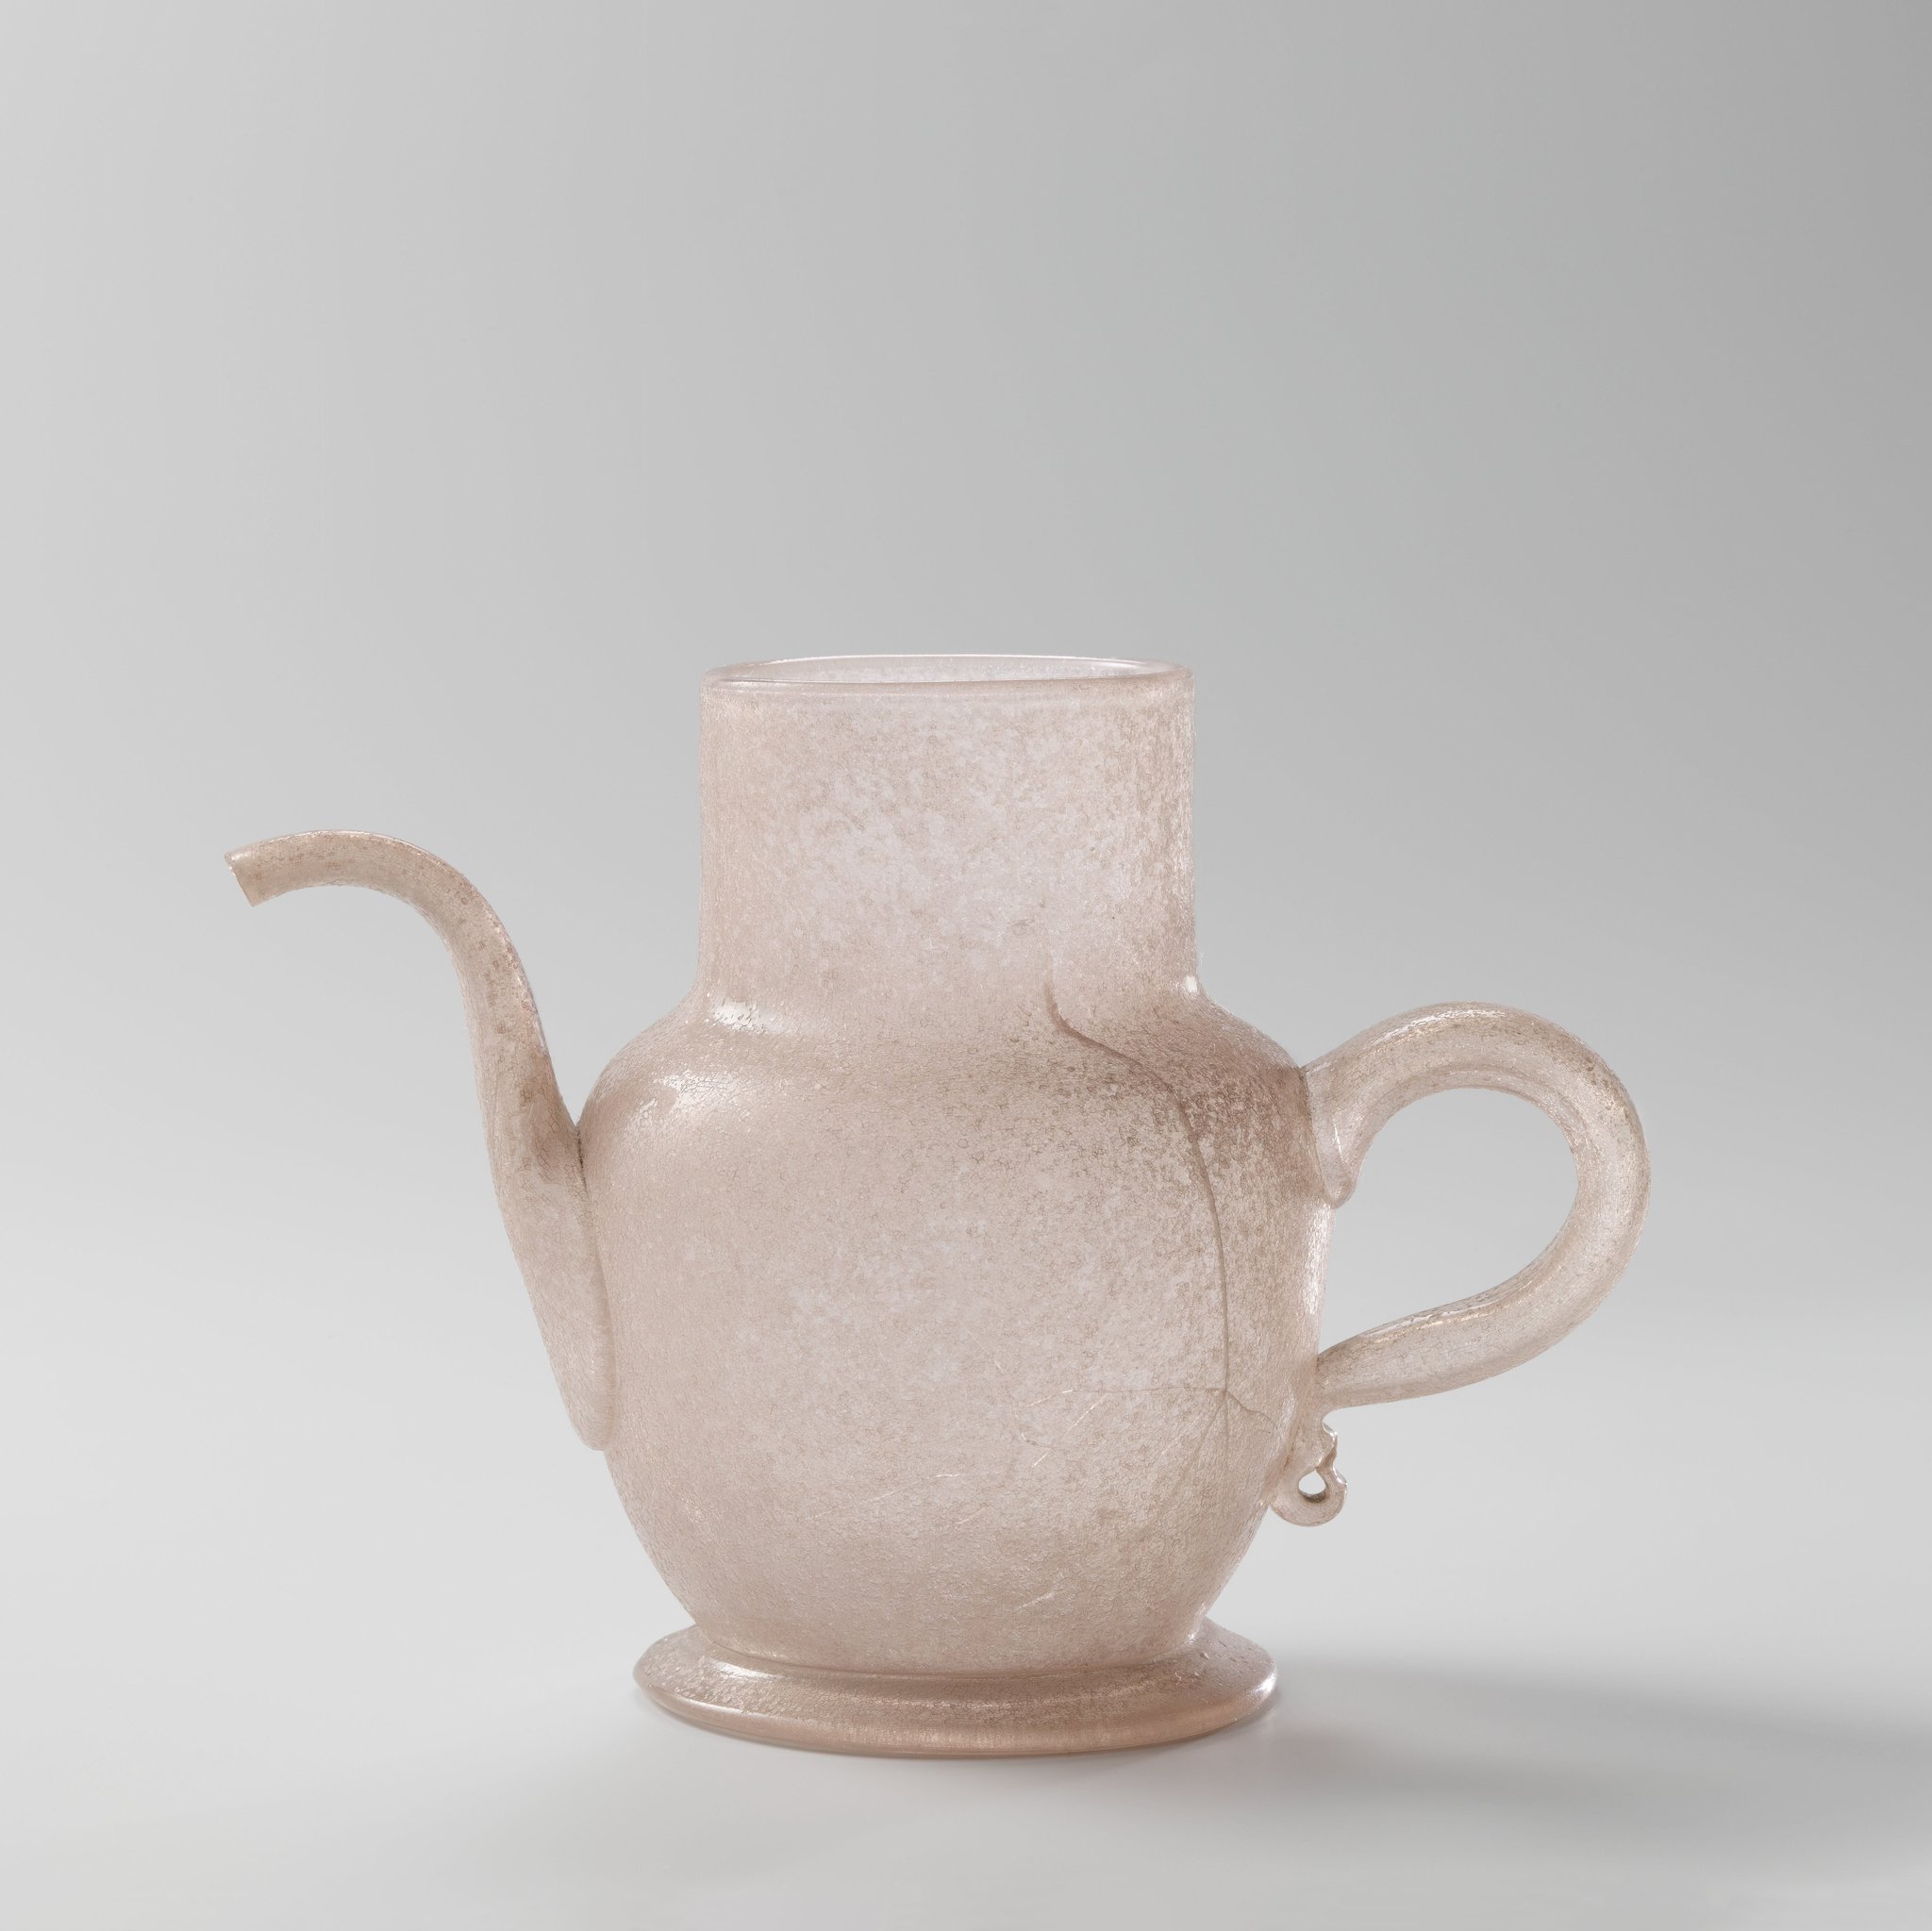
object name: tuitkan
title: Tuitkan met eivormig lichaam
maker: Anonymous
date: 1700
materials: glass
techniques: glassblowing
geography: england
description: Platte standring, eivormig lichaam overgaand in een rechte hals. Gebogen tuit en hol, c-vormig oor.